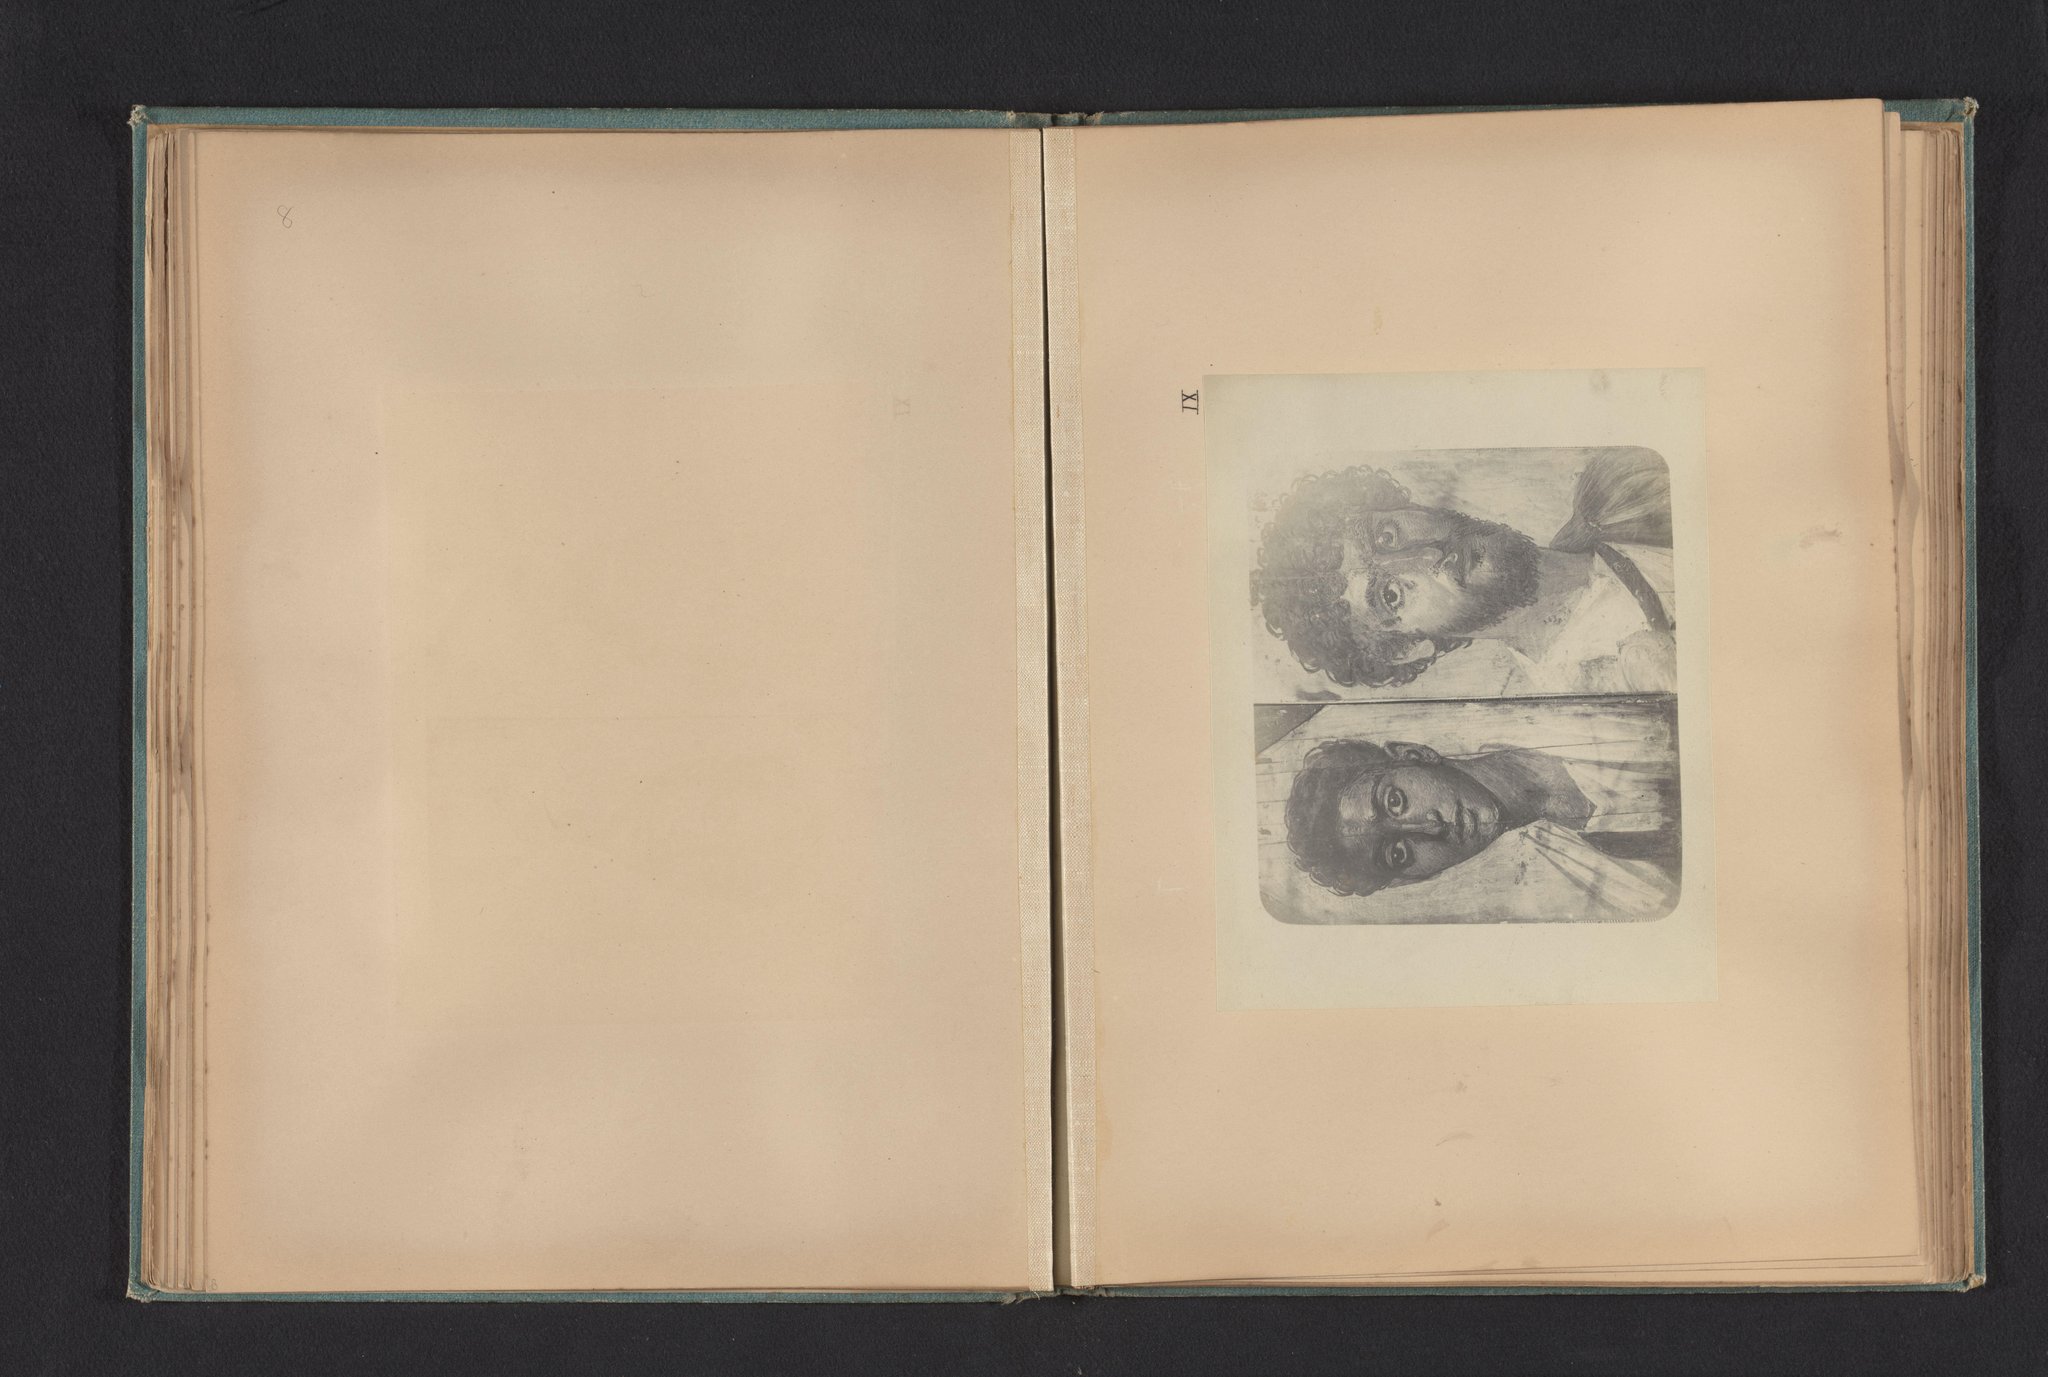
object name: photograph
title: Twee fajoemportretten van mannen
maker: Anonymous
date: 1890-1895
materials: photographic support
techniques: gelatin silver print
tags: adult woman, historical persons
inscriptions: number: ‘IX’